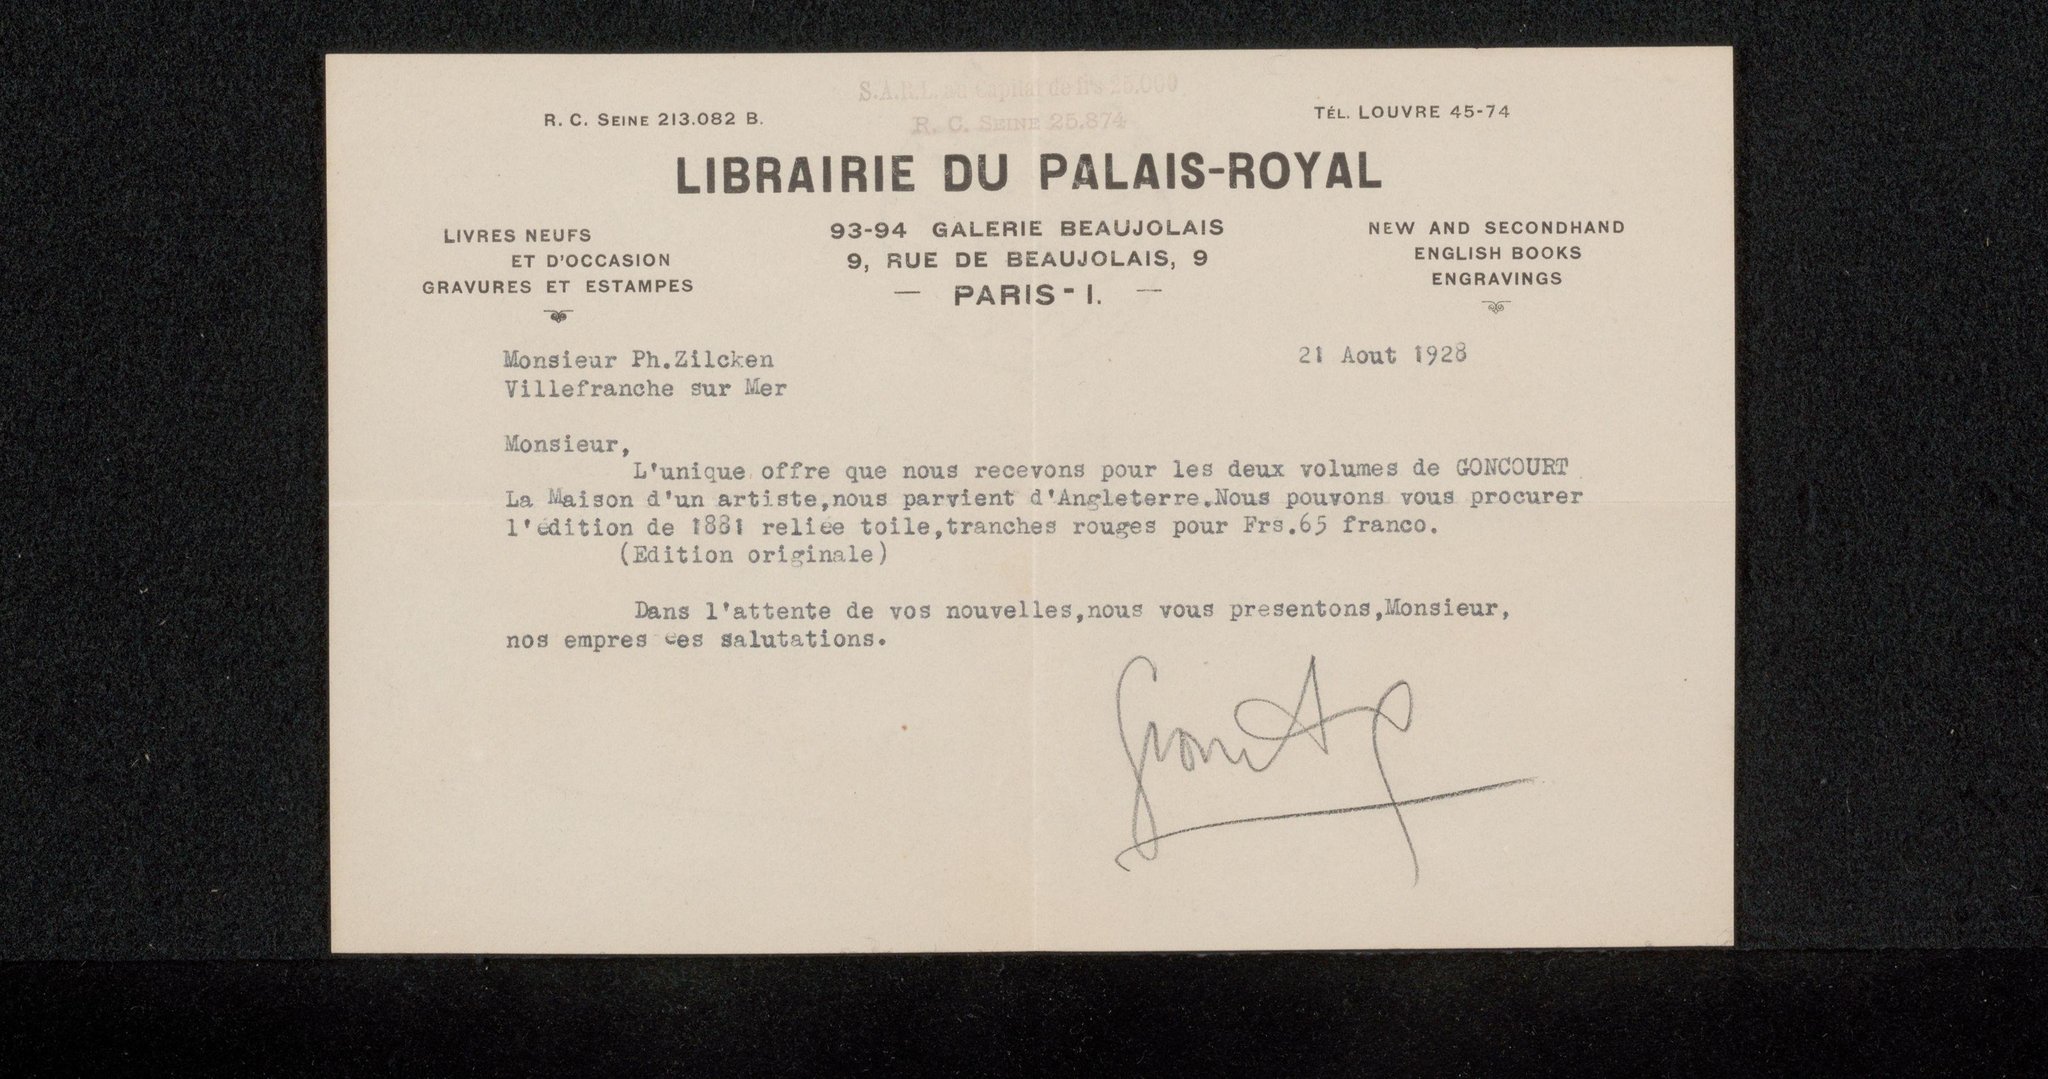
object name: letter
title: Brief aan Philip Zilcken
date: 1928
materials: ink, paper, pencil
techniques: typewriting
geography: paris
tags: painter, draughtsman, edmond de goncourt, the hague, philip zilcken, literature ~ arts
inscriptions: collector's mark: ‘RPK’